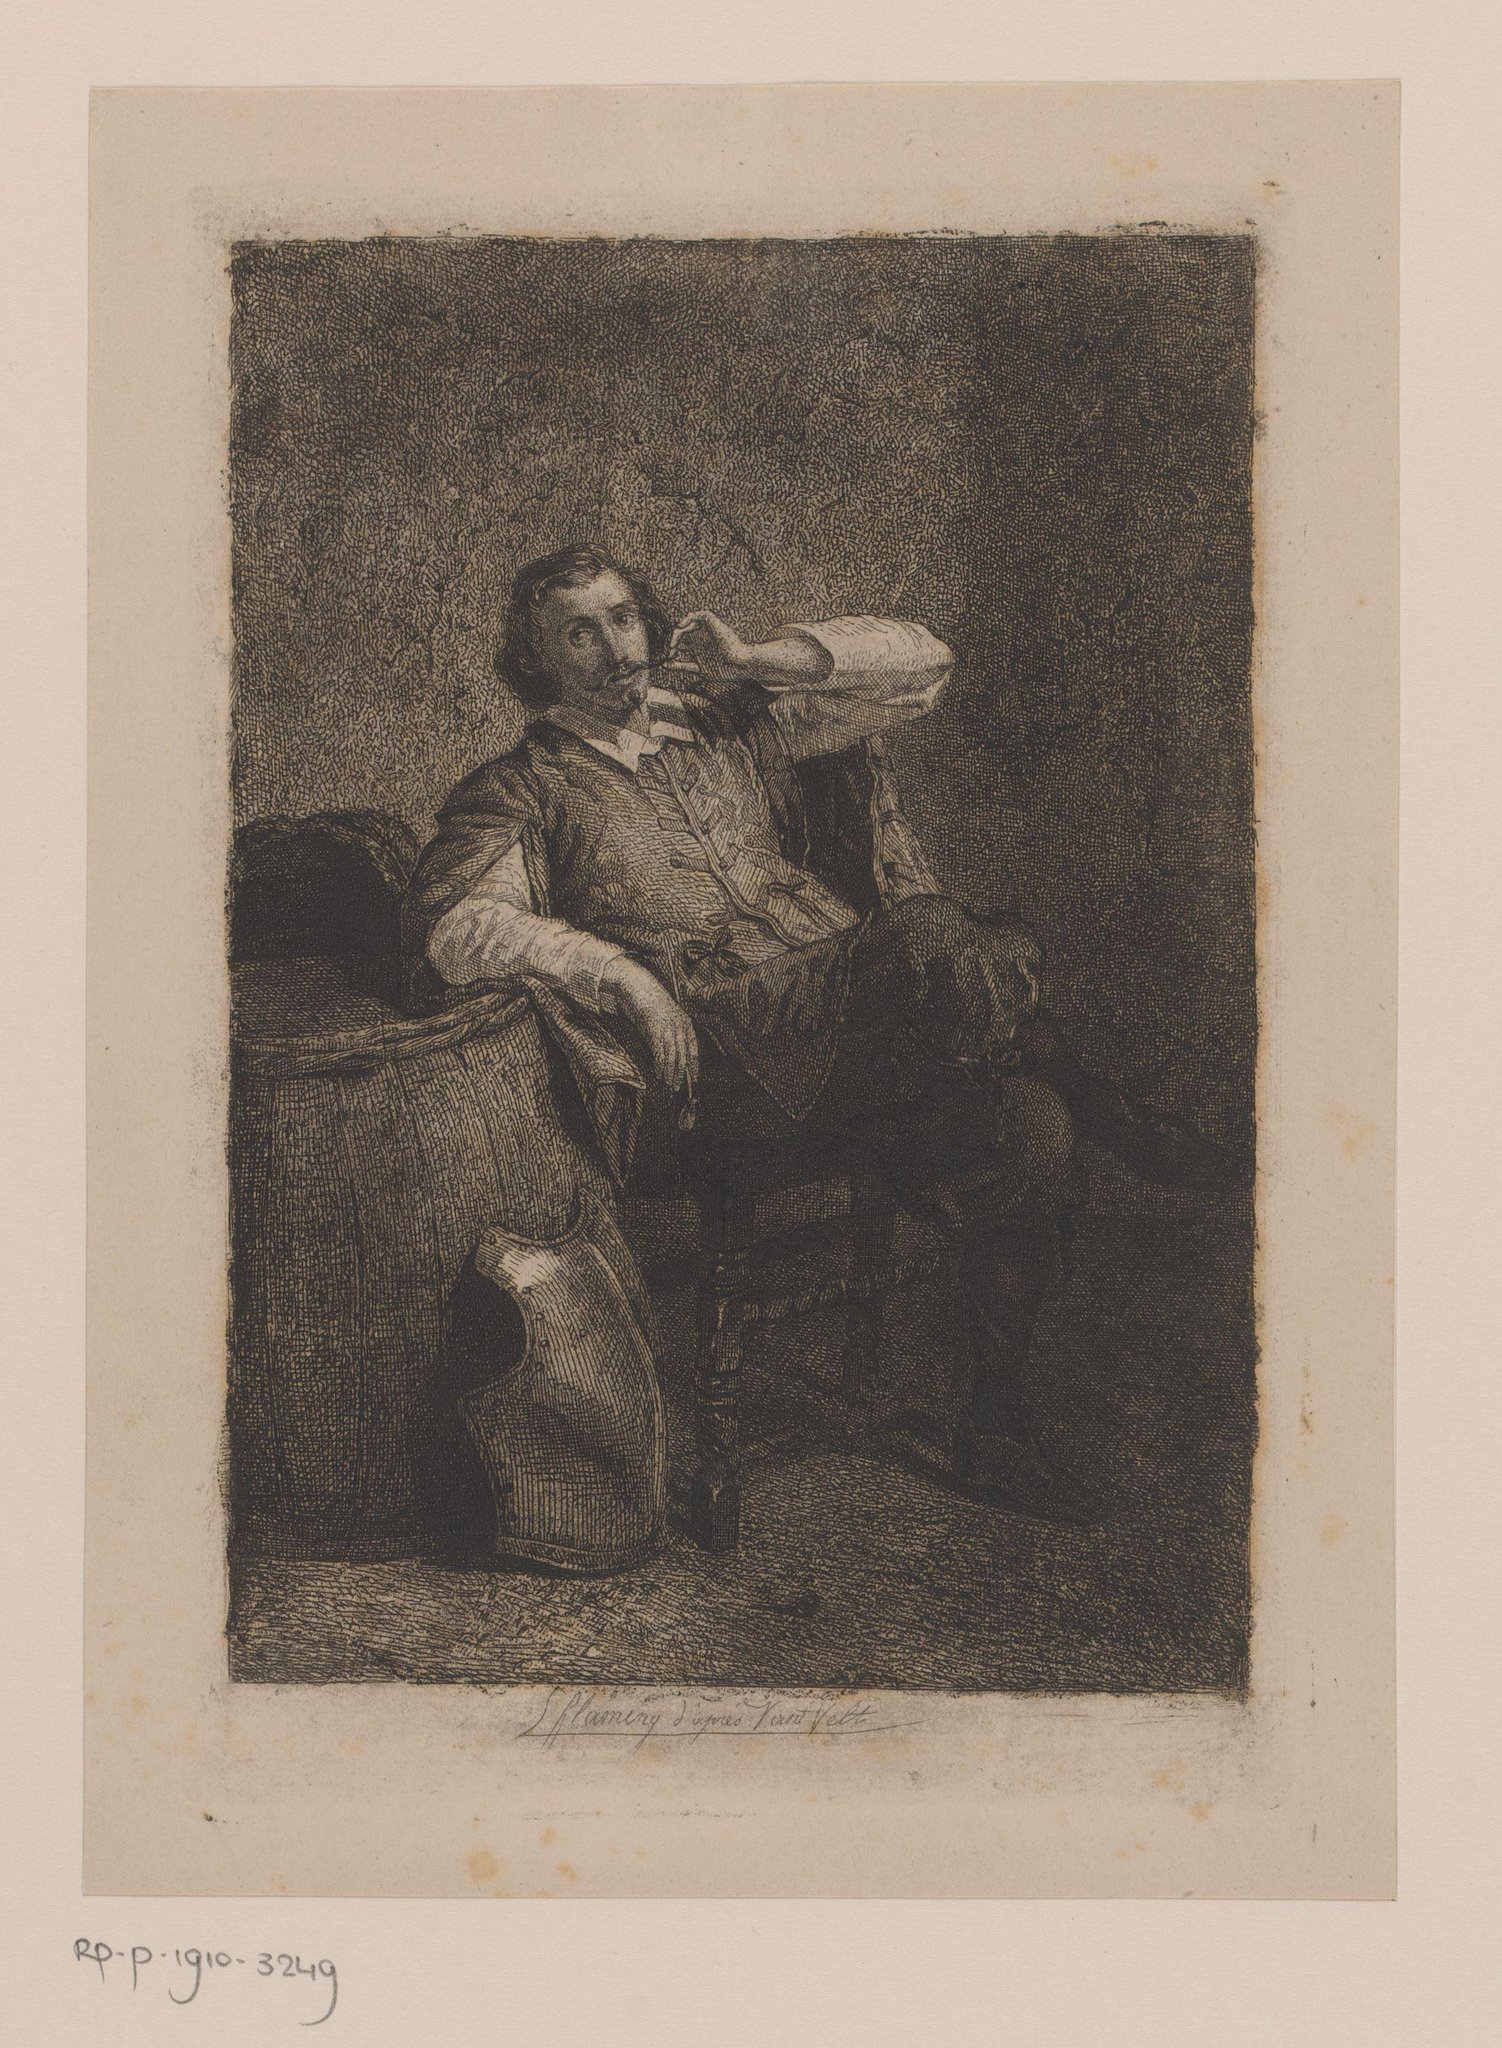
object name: print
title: Rustende soldaat met een kuras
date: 1841-1874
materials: paper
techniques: etching, intaglio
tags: in the guard-room, 'kortegaard'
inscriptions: collector's mark: Lugt 1485, collector's mark: Lugt 2228